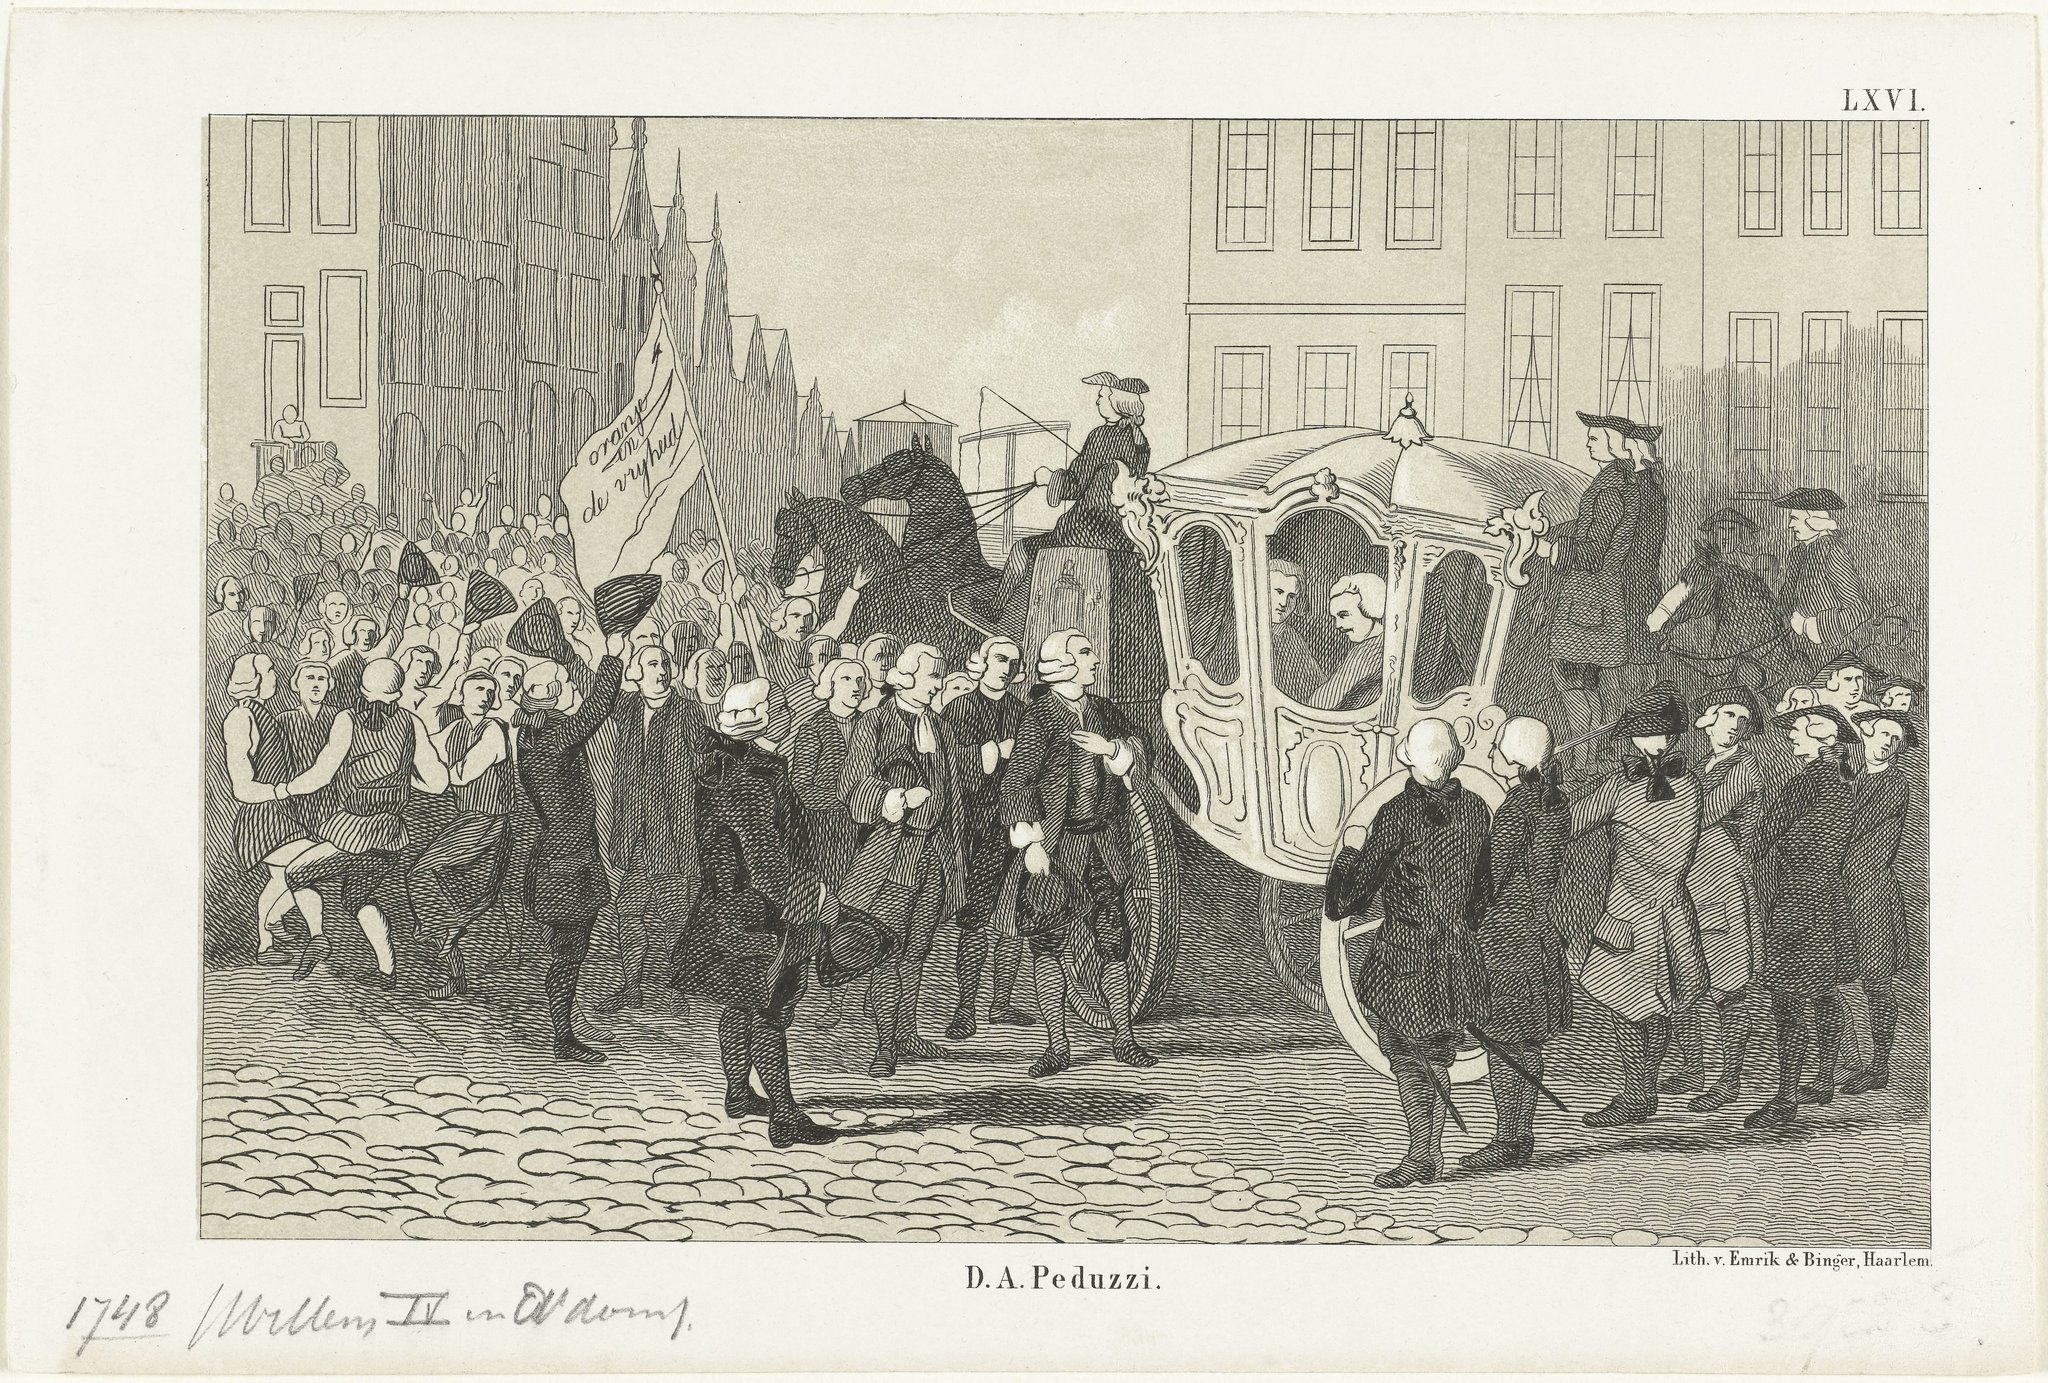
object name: print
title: Aankomst van Willem IV te Amsterdam, 1748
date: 1853-1861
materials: paper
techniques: tone lithography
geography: netherlands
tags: the hague, willem iv (prins van oranje-nassau), triumphal entry and public reception, pageant, 'entrée solennelle', 'joyeuse entrée', amsterdam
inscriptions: collector's mark: Lugt 2228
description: Gebruikt als illustratie in: Jacob van Lennep, De geschiedenis des vaderlands in schetsen en afbeeldingen, Binger, Amsterdam 1855-1861, 8 delen, pl. LXVI. Dit nummer is een door het RPK toegevoegd nummer en staat niet in Frederik Muller, het werk waar de prent voor is gemaakt of uit afkomstig is, staat wel vermeld in Frederik Muller.